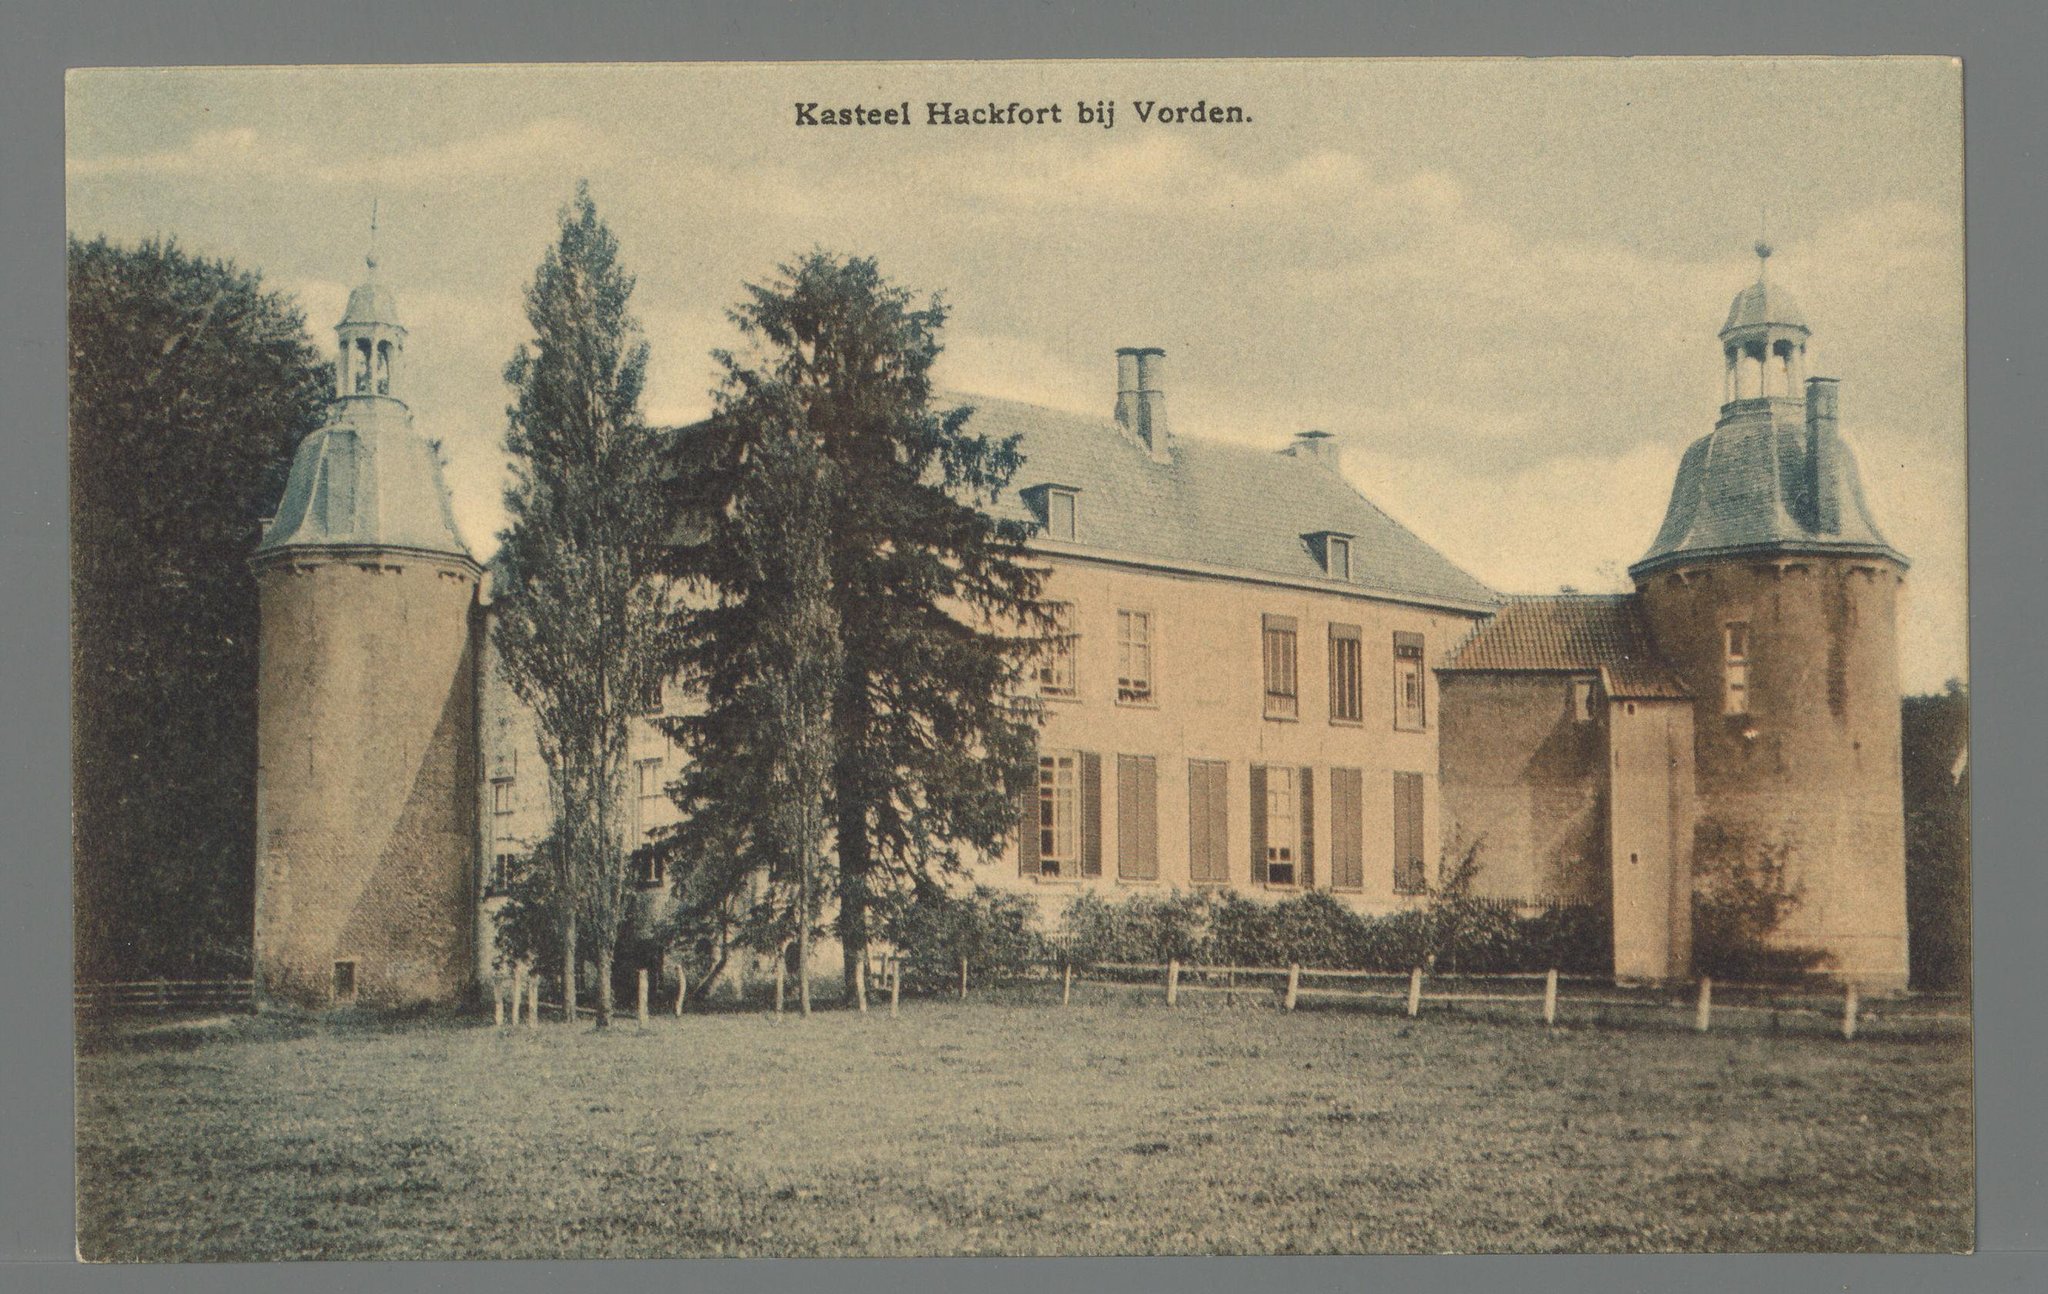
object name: photomechanical print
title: Kasteel Hackfort bij Vorden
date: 1905-1930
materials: cardboard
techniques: collotype process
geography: amsterdam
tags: castle